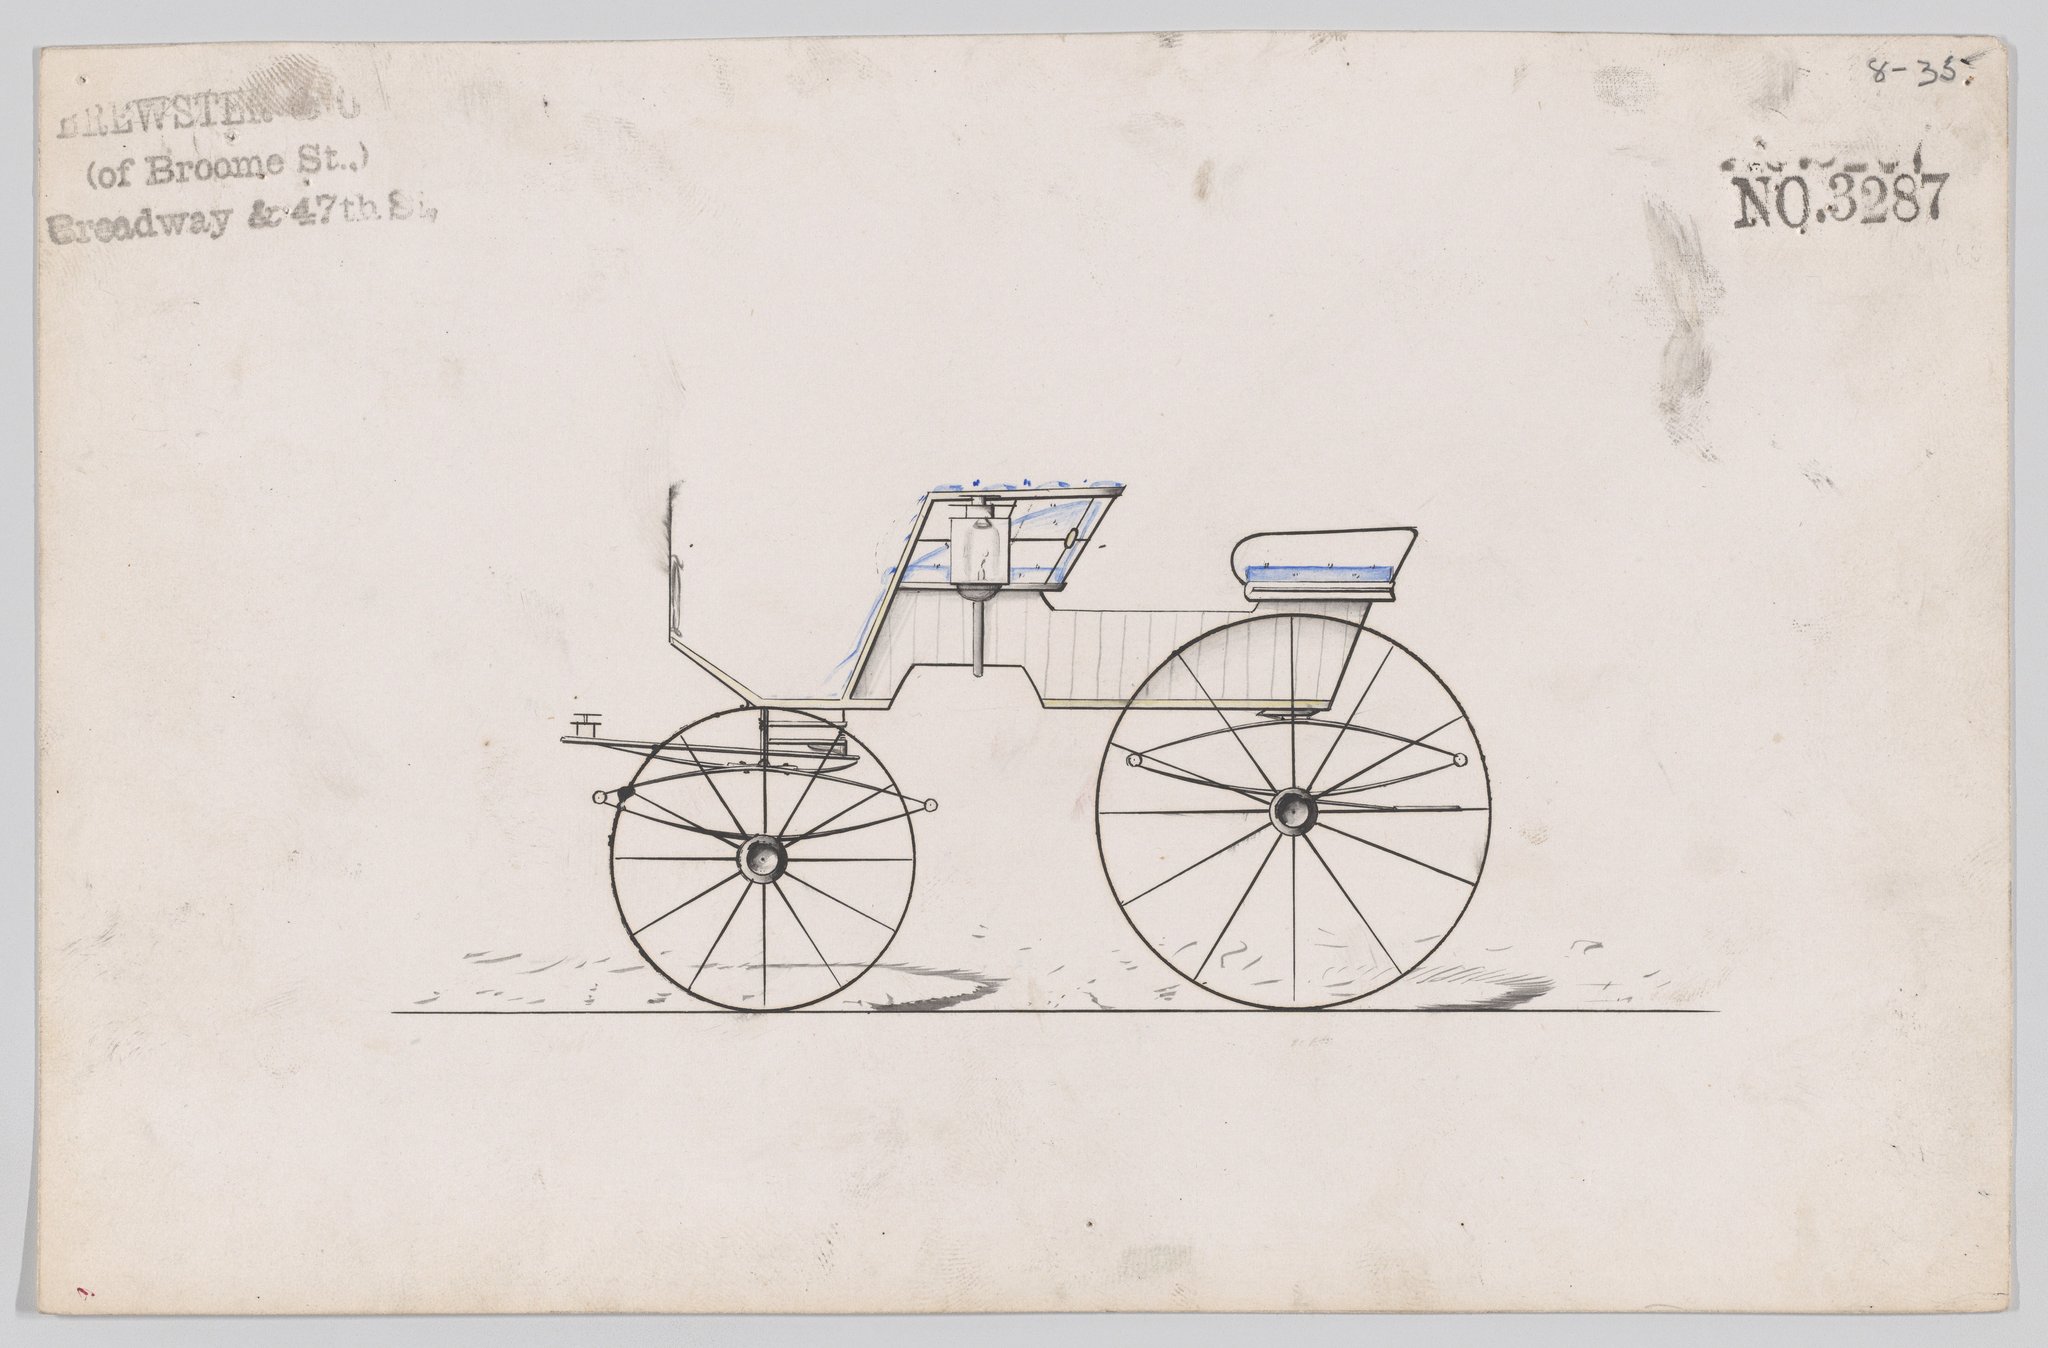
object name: drawing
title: Design for 4 seat Phaeton, no top, no. 3287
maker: brewster & co.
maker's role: manufacturer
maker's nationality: american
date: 1876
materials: gouache, ink, watercolor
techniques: pen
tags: carriages